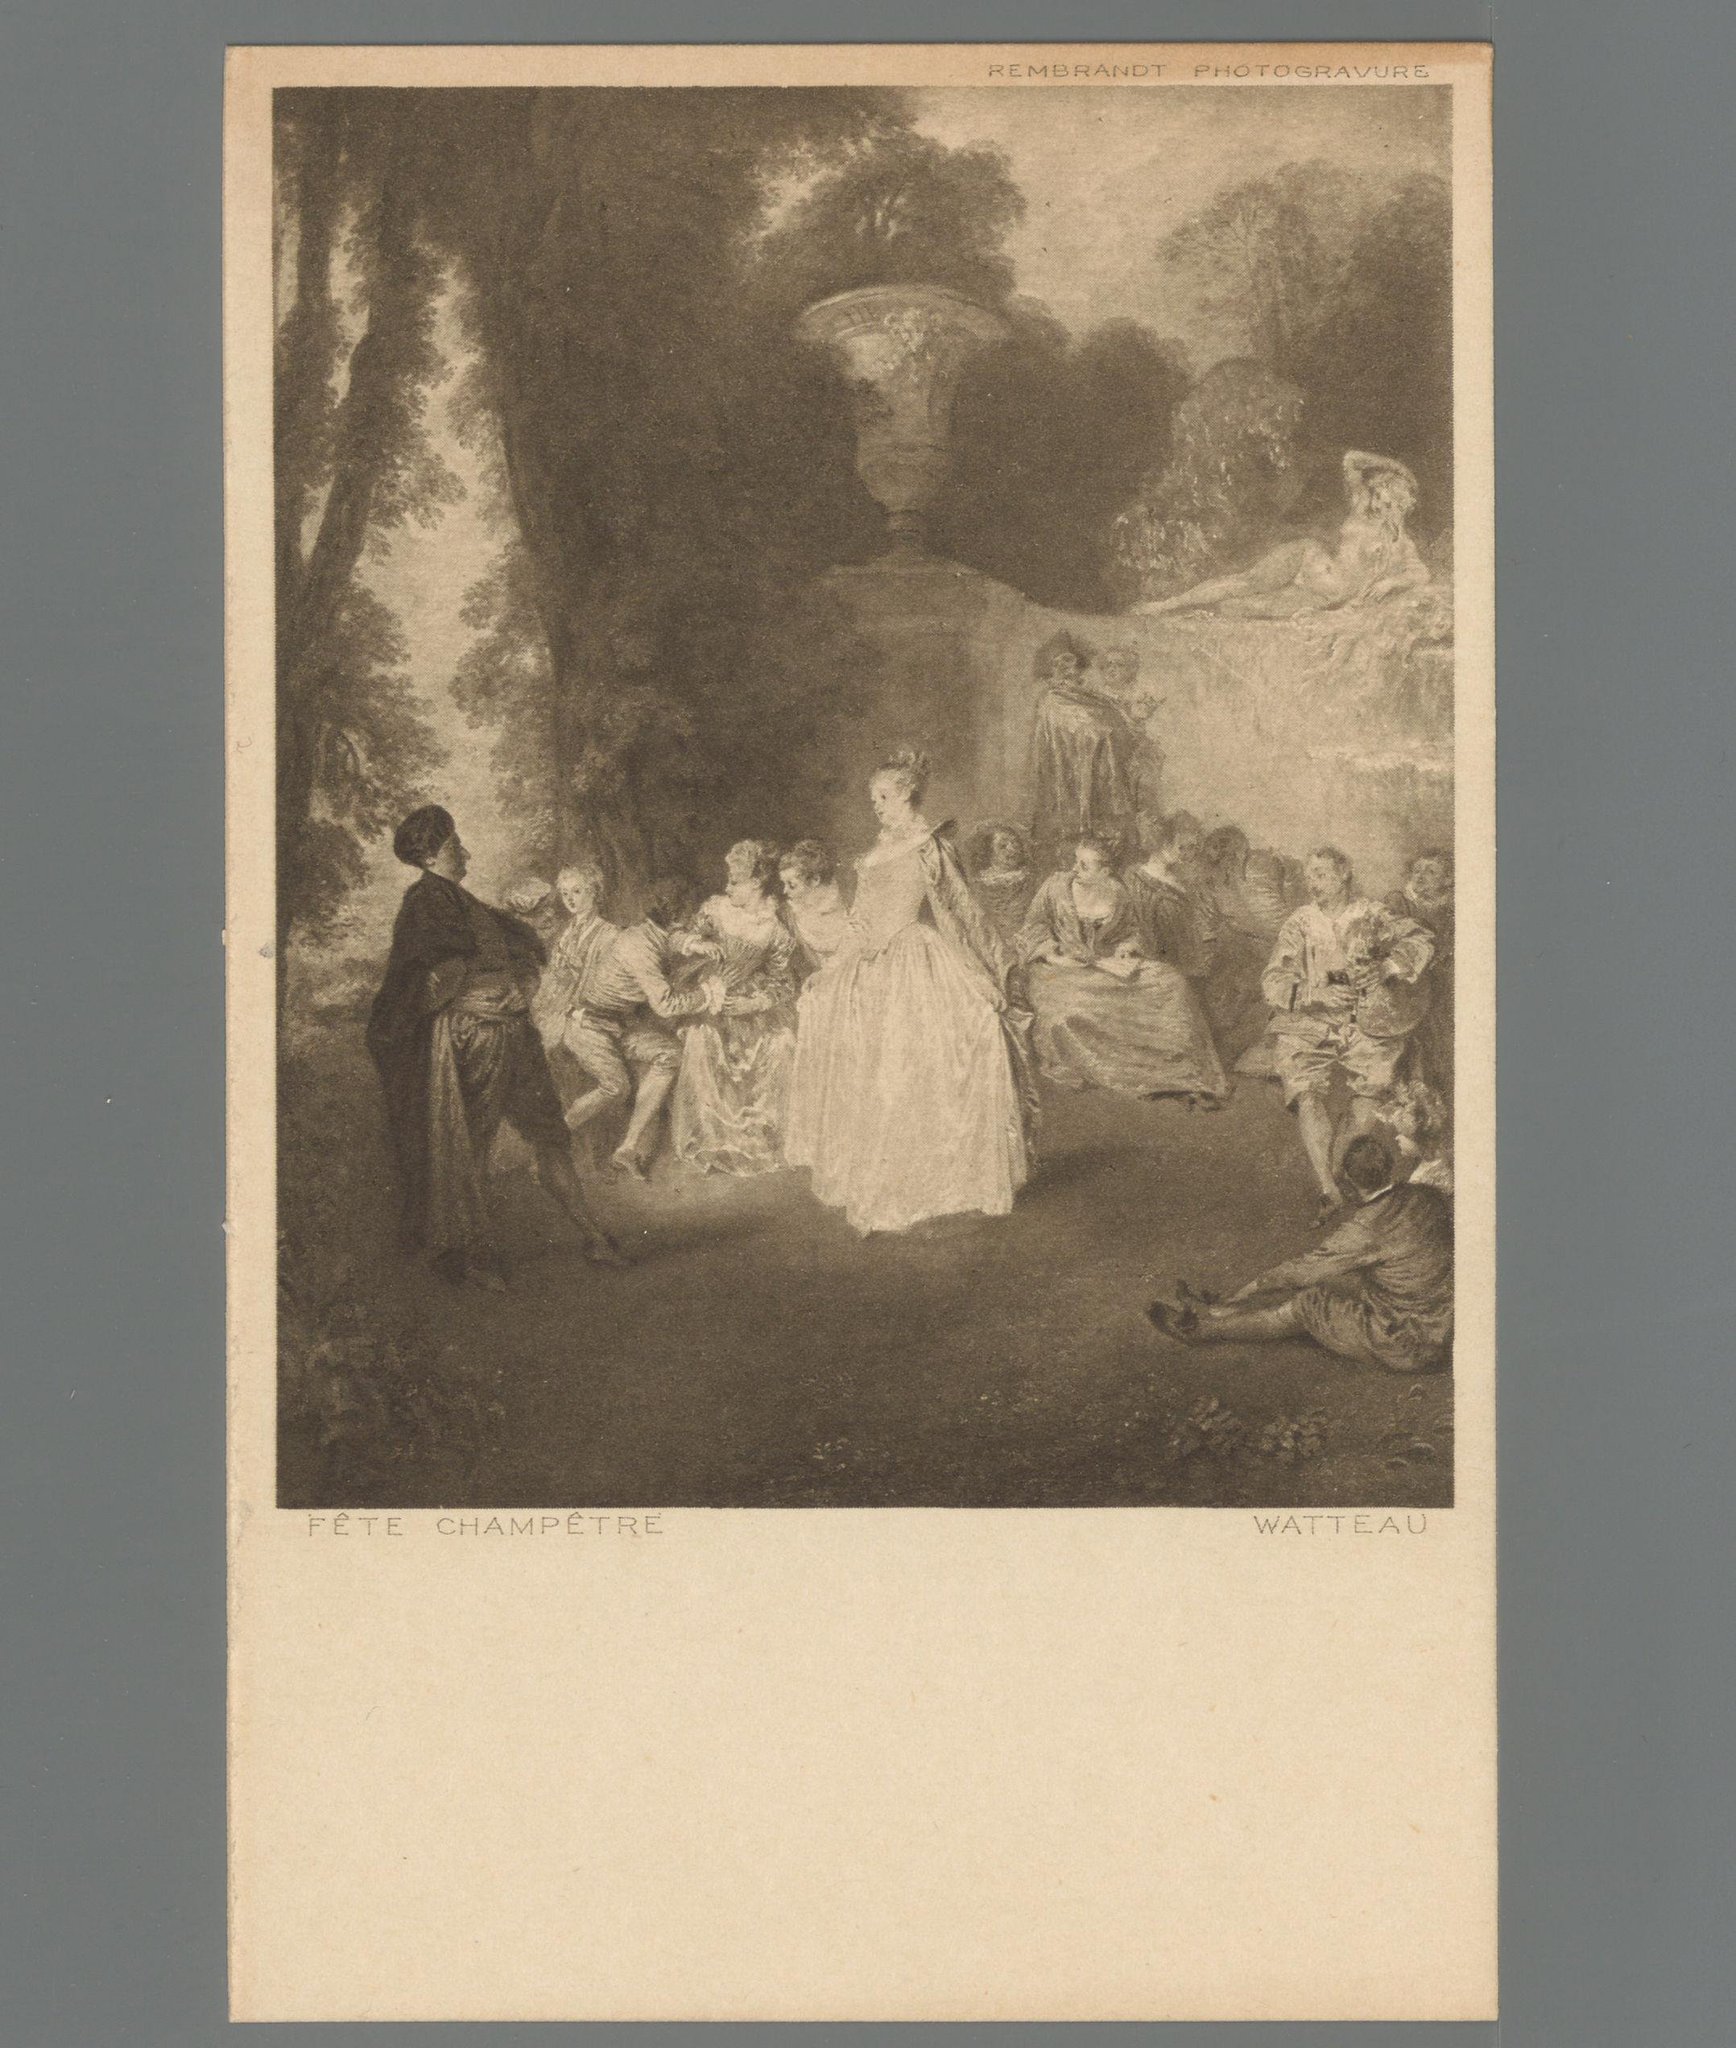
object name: photomechanical print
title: Fête Champêtre. Watteau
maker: jean antoine watteau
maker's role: draughtsman, print maker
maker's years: 1684-1721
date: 1902-1930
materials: cardboard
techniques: rotogravure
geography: glasgow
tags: permanent exhibition, museum, picture, painting